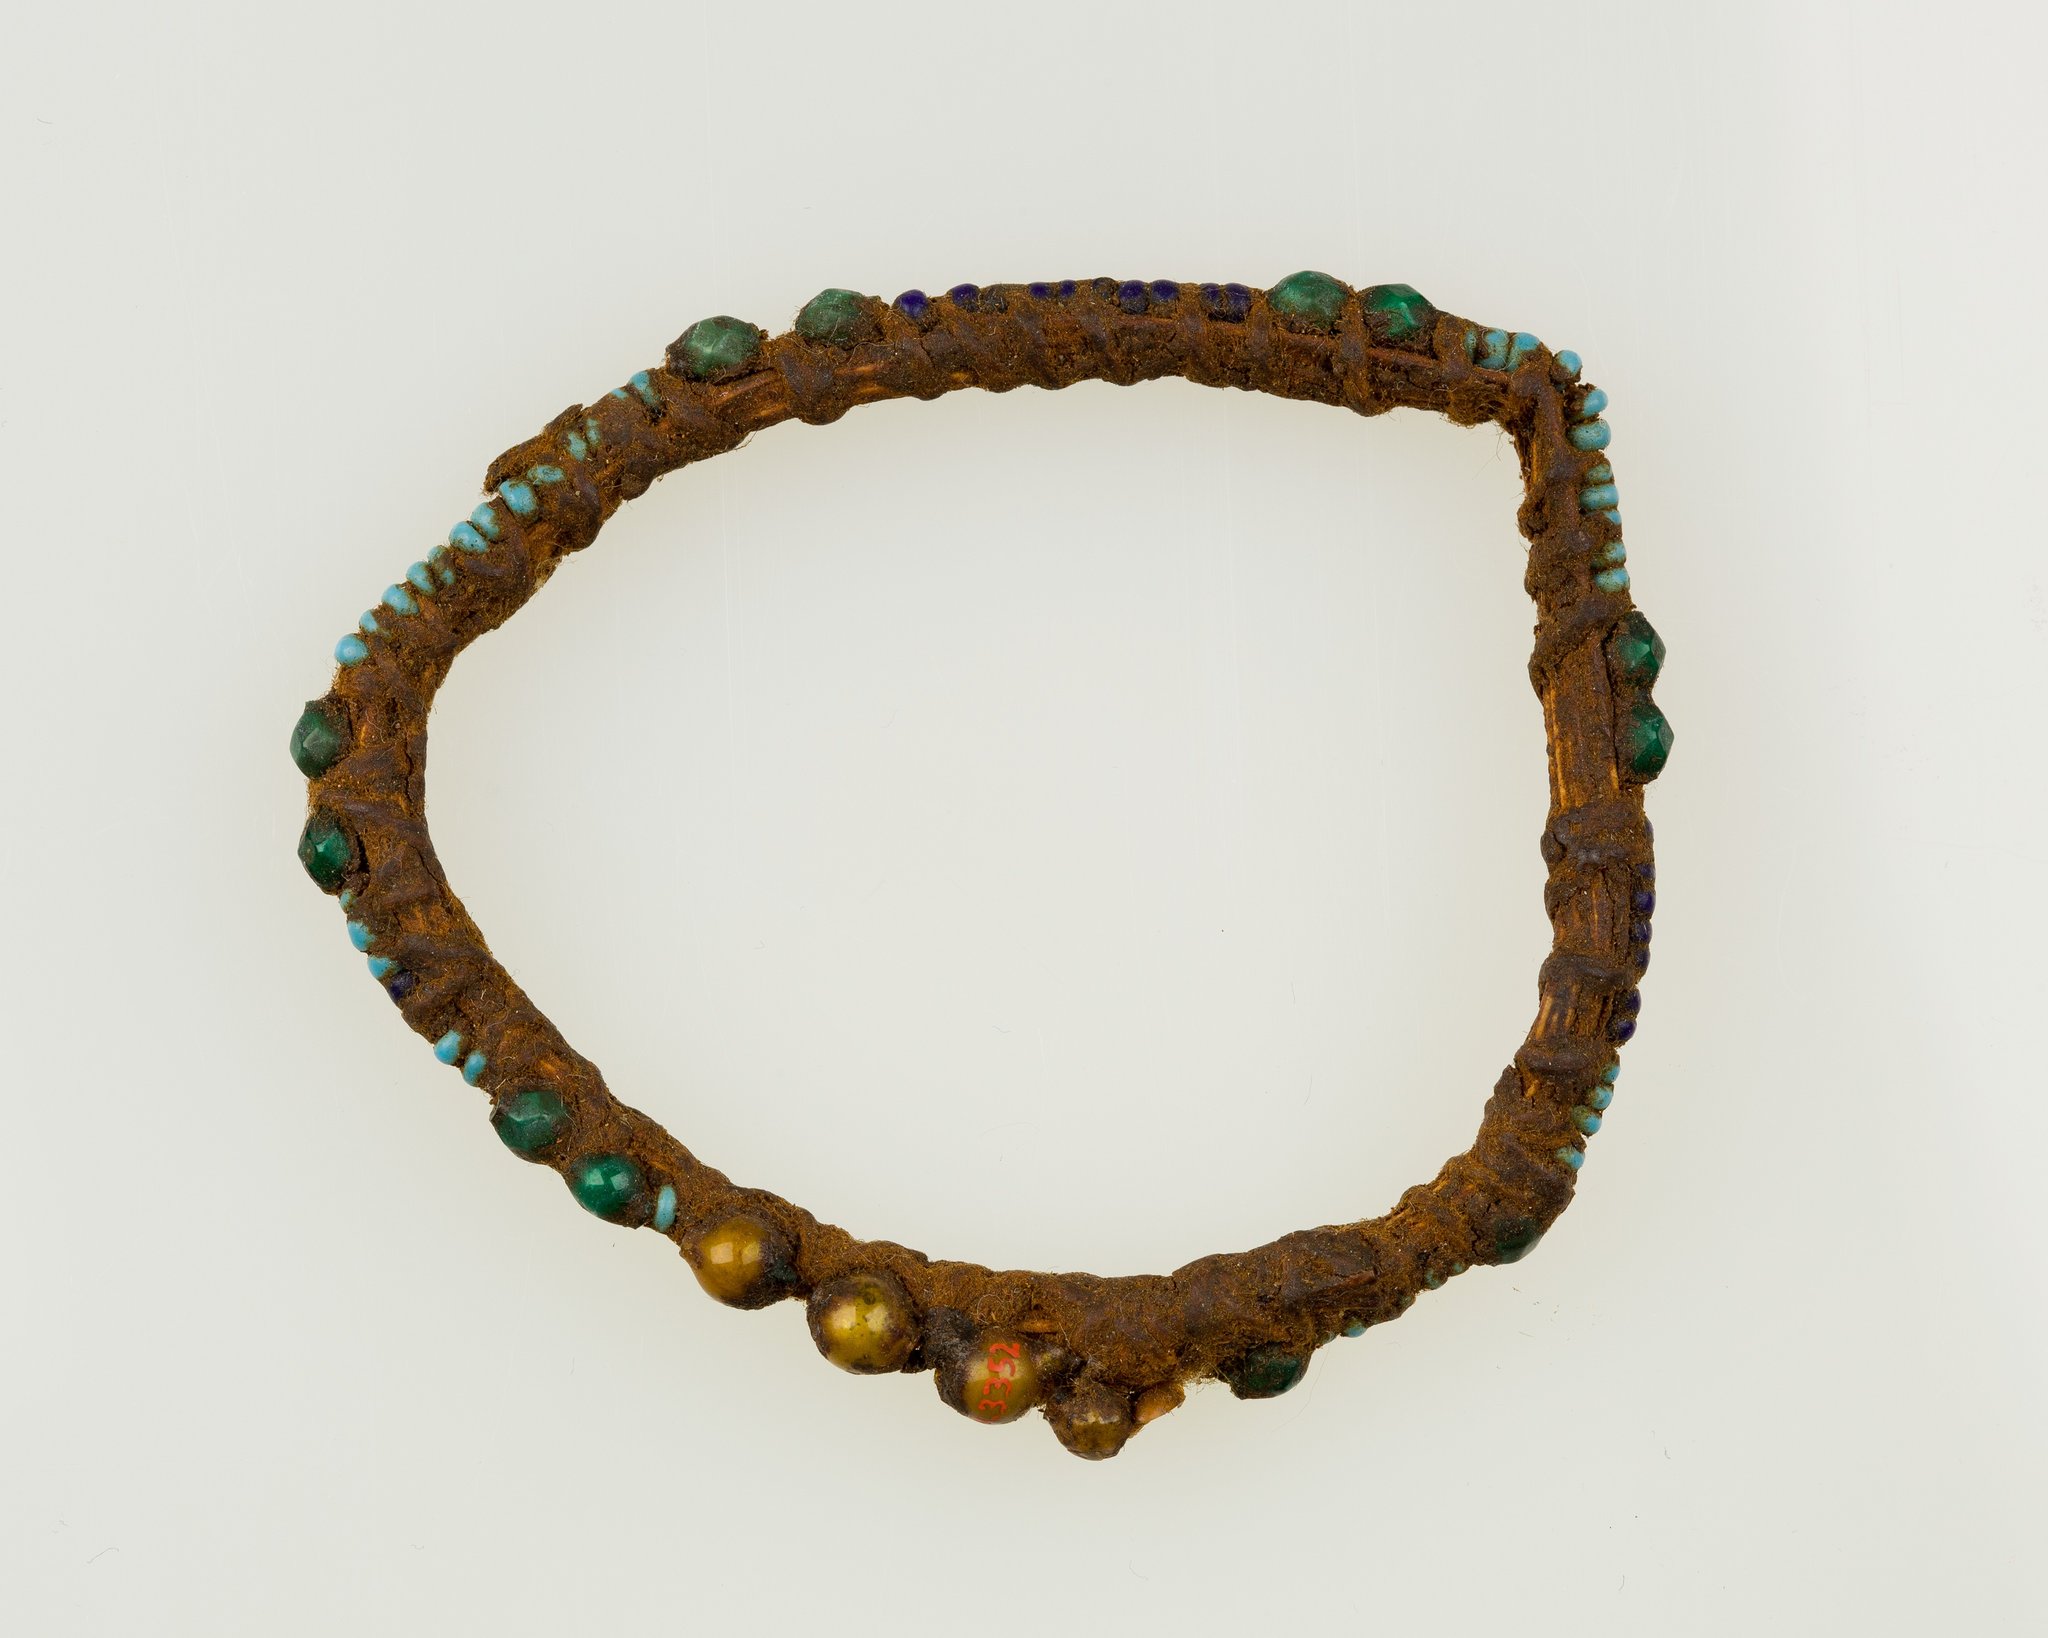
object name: bracelet, bead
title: Bracelet of beads strung on fiber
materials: fiber, glass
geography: egypt